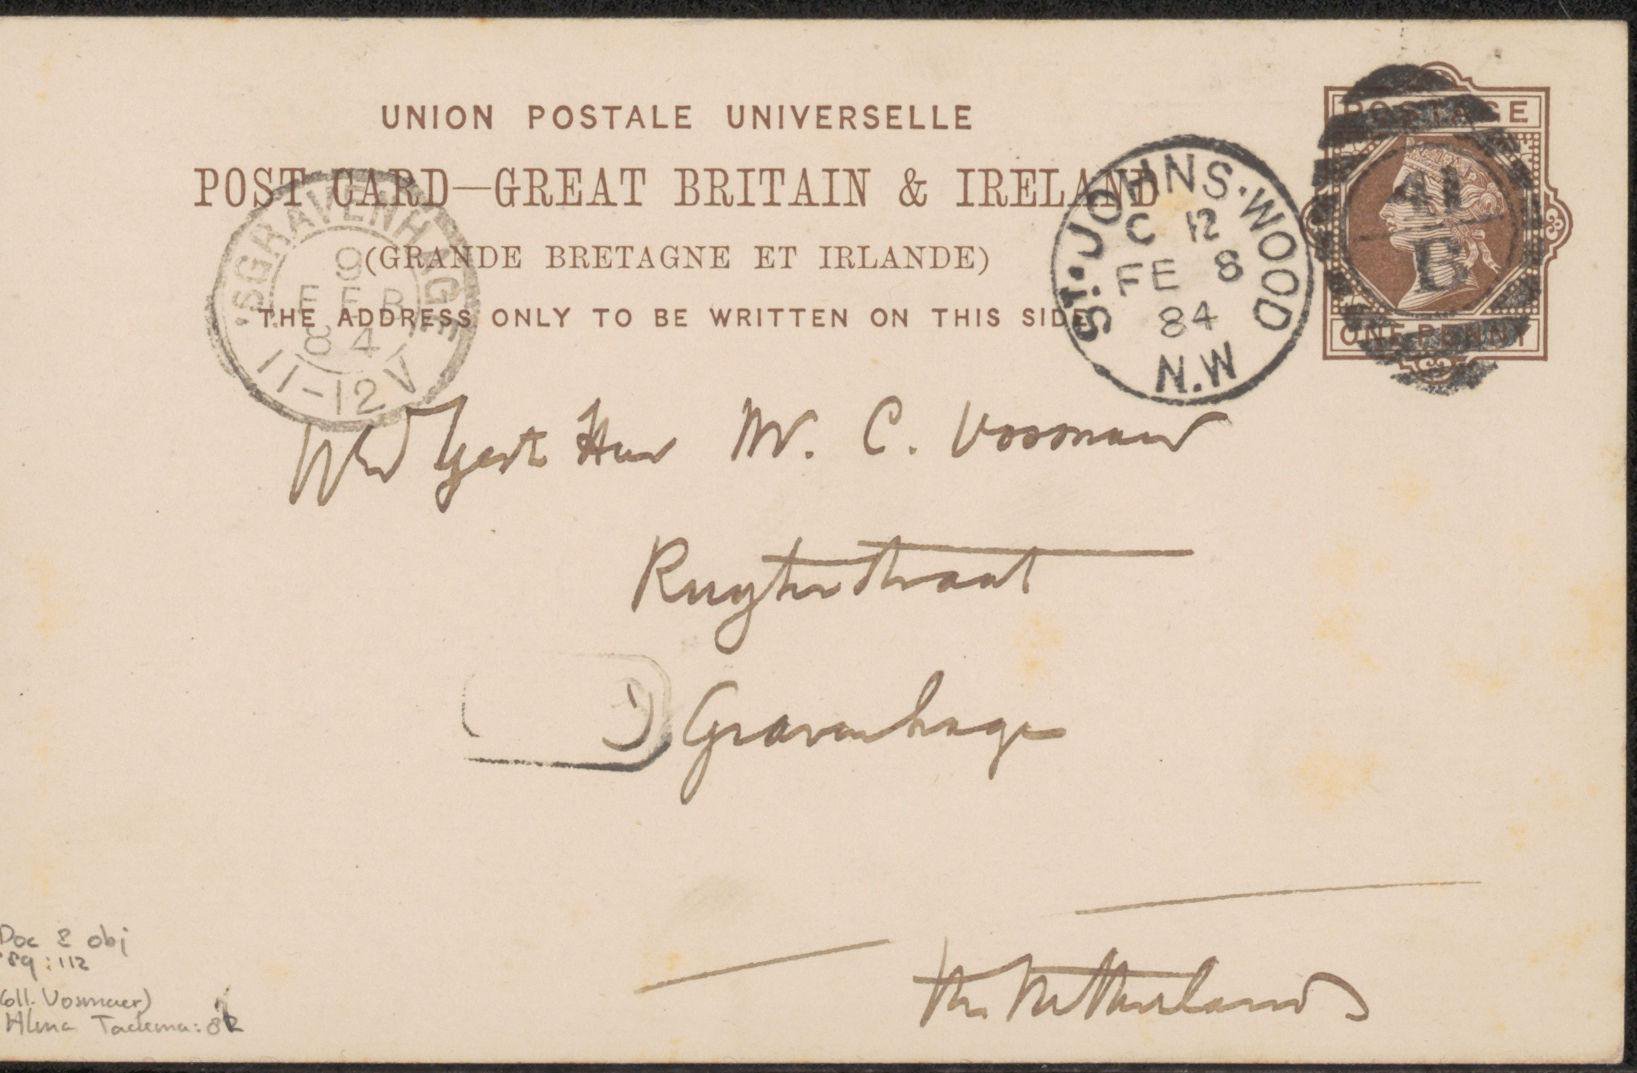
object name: postcard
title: Briefkaart aan Carel Vosmaer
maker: lourens alma tadema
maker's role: draughtsman, print maker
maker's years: 1836-1912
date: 1884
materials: cardboard, ink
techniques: pen, writing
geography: london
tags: carel vosmaer, the graphic arts, historical persons (portraits and scenes from the life)